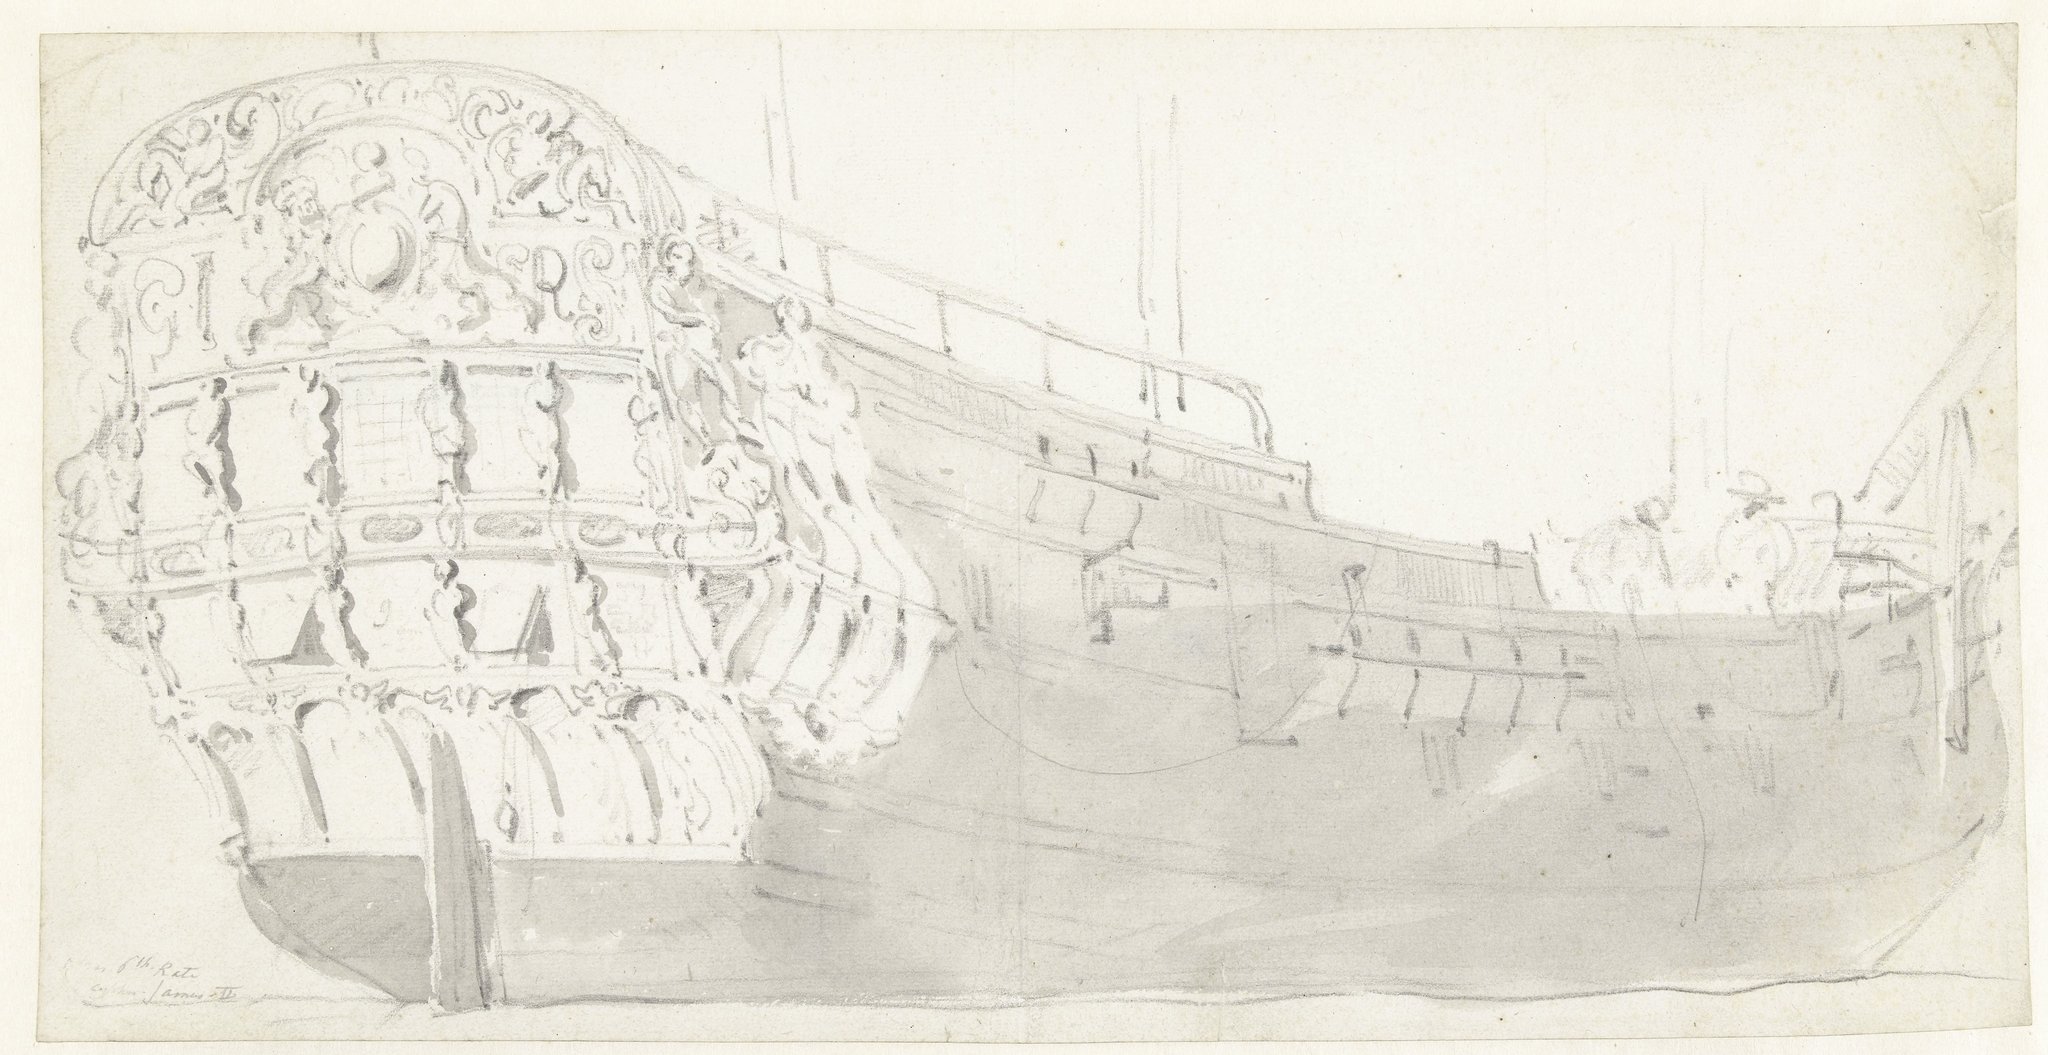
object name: drawing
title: De spiegel van het Engelse schip James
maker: willem van de velde (ii)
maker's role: draughtsman, painter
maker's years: 1633-1707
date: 1643-1707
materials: paper, pencil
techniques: brush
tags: sailing-ship, sailing-boat, names of artefacts and man-made objects (buildings excluded), navy (+ sailing-ships)